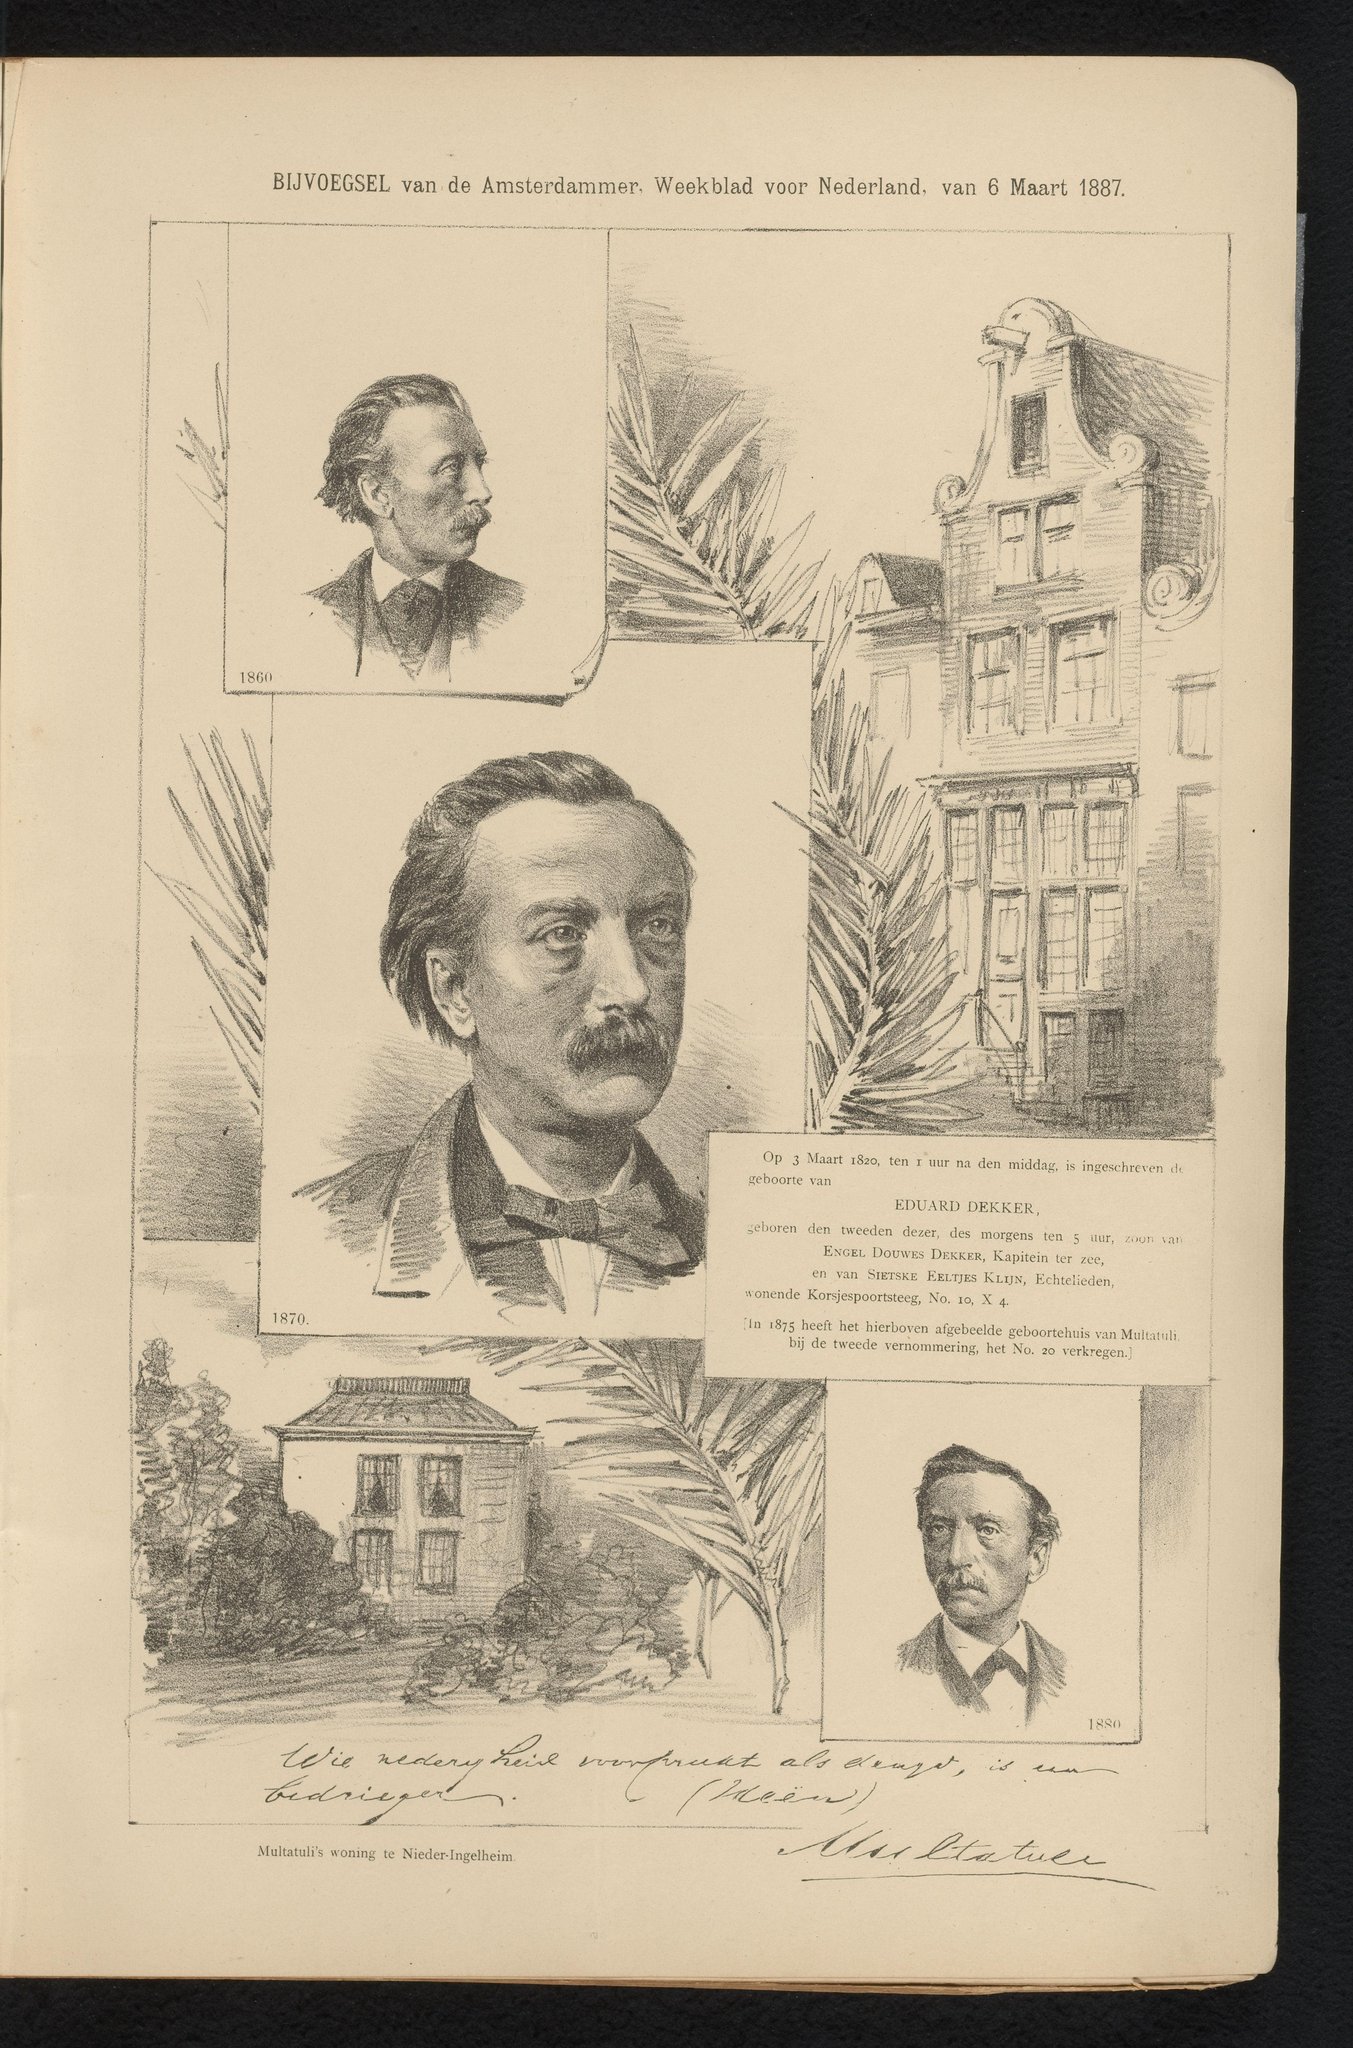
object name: print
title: Bij het overlijden van Multatuli, 1887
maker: johan braakensiek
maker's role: draughtsman, print maker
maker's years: 1858-1940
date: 1887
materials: paper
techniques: lithograph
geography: netherlands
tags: multatuli, historical persons, writer, poet, author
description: Drie portretten en afbeeldingen van twee huizen, ter nagedachtenis aan de schrijver Multatuli, overleden 19 februari 1887.